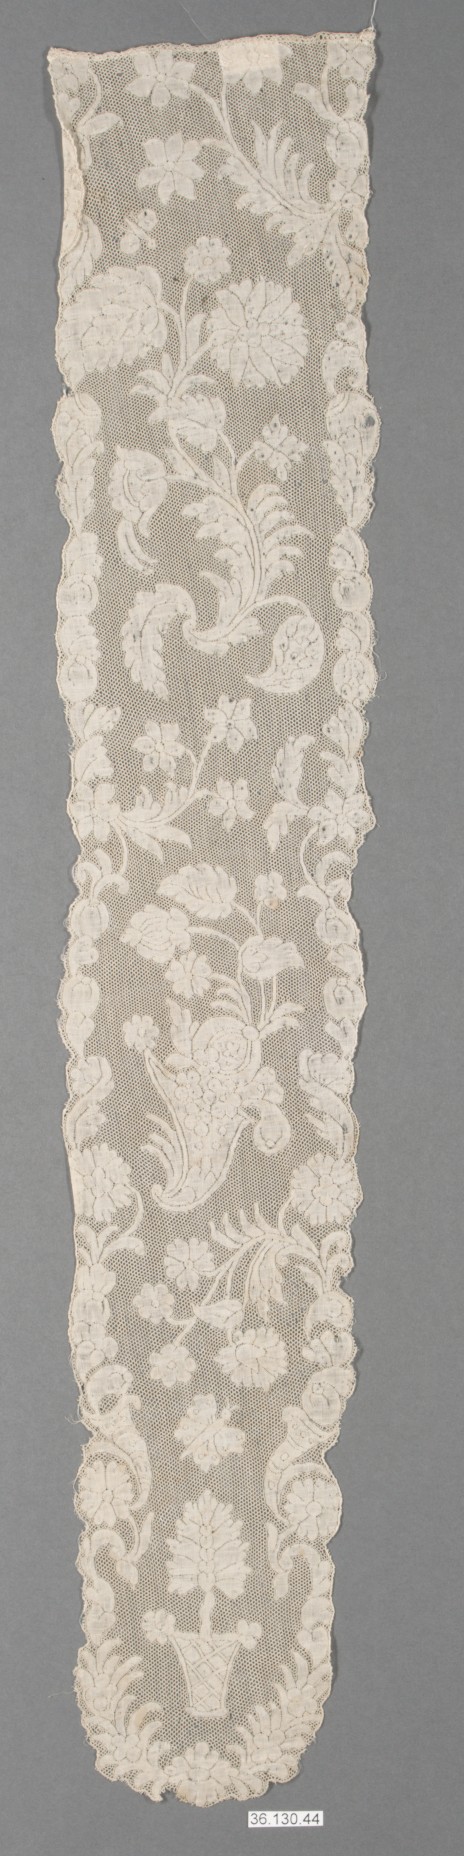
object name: lappet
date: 1701-1800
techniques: lace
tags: flowers